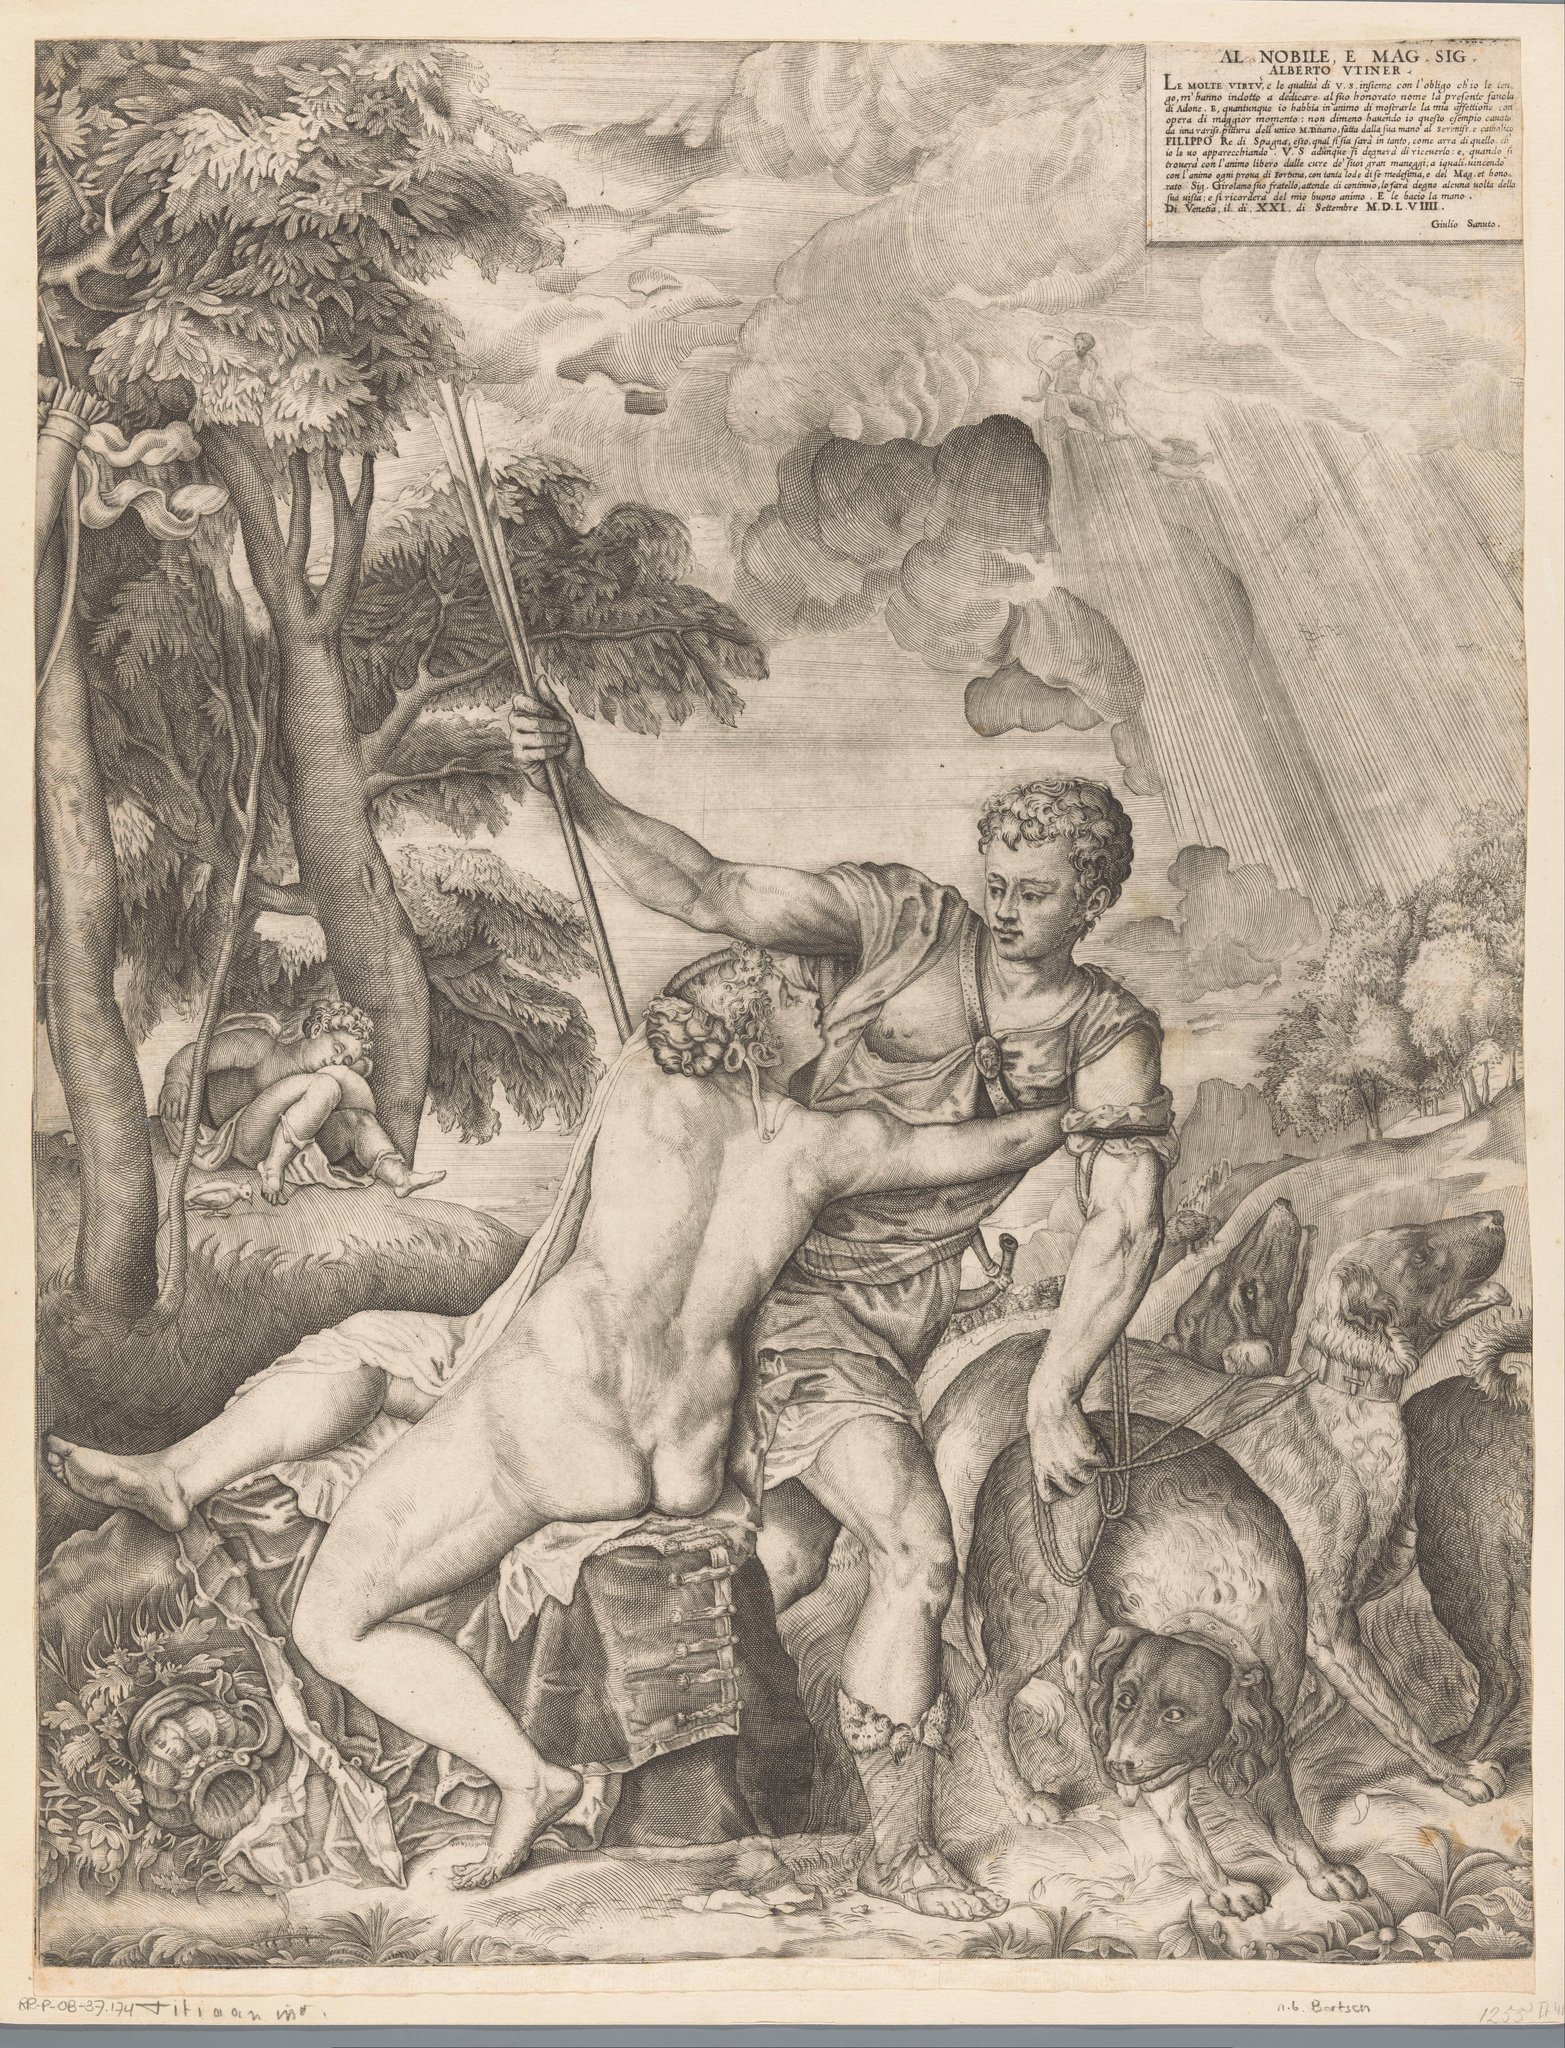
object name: print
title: Venus en Adonis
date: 1559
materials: paper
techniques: engraving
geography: italy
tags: philip ii of spain, venus trying to prevent adonis from going hunting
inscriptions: collector's mark: Lugt 240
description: Venus probeert Adonis te weerhouden op jacht te gaan. De naakte Venus heeft haar armen om Adonis heen geslagen. Adonis staat echter met speer en jachthonden klaar om te vertrekken. Links ligt Amor te slapen onder een boom. Rechtsboven een tekstvak met opdracht in het Italiaans.